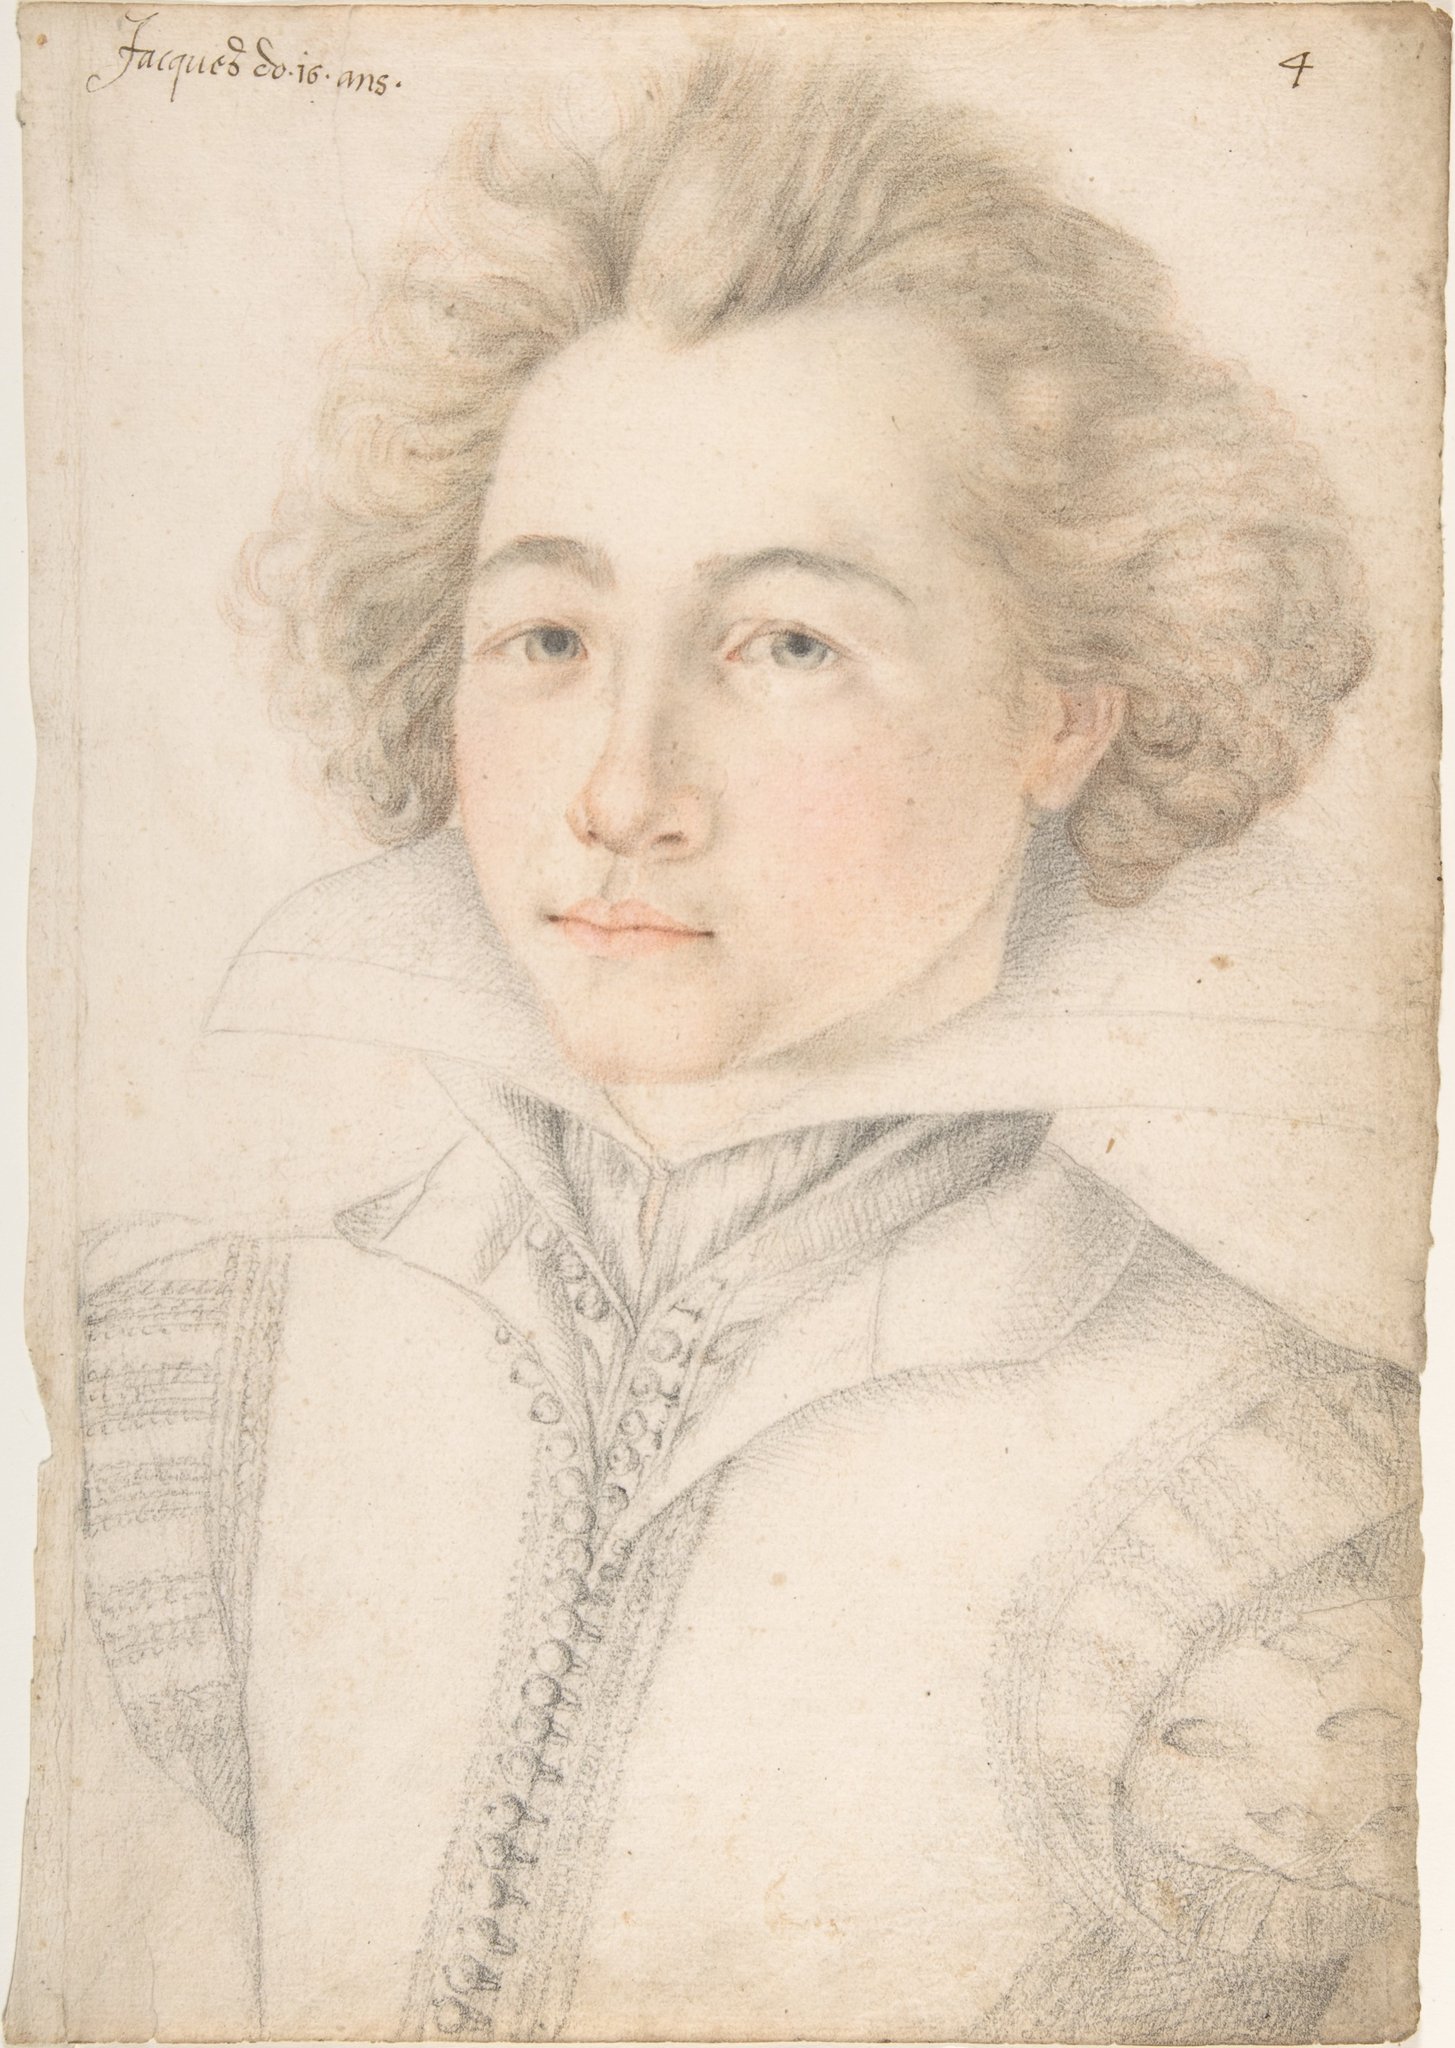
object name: drawing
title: Portrait of Jacques d'O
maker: anonymous, french, 16th century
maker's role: artist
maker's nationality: french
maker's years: 1500-1600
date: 1500-1600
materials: chalk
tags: men,portraits